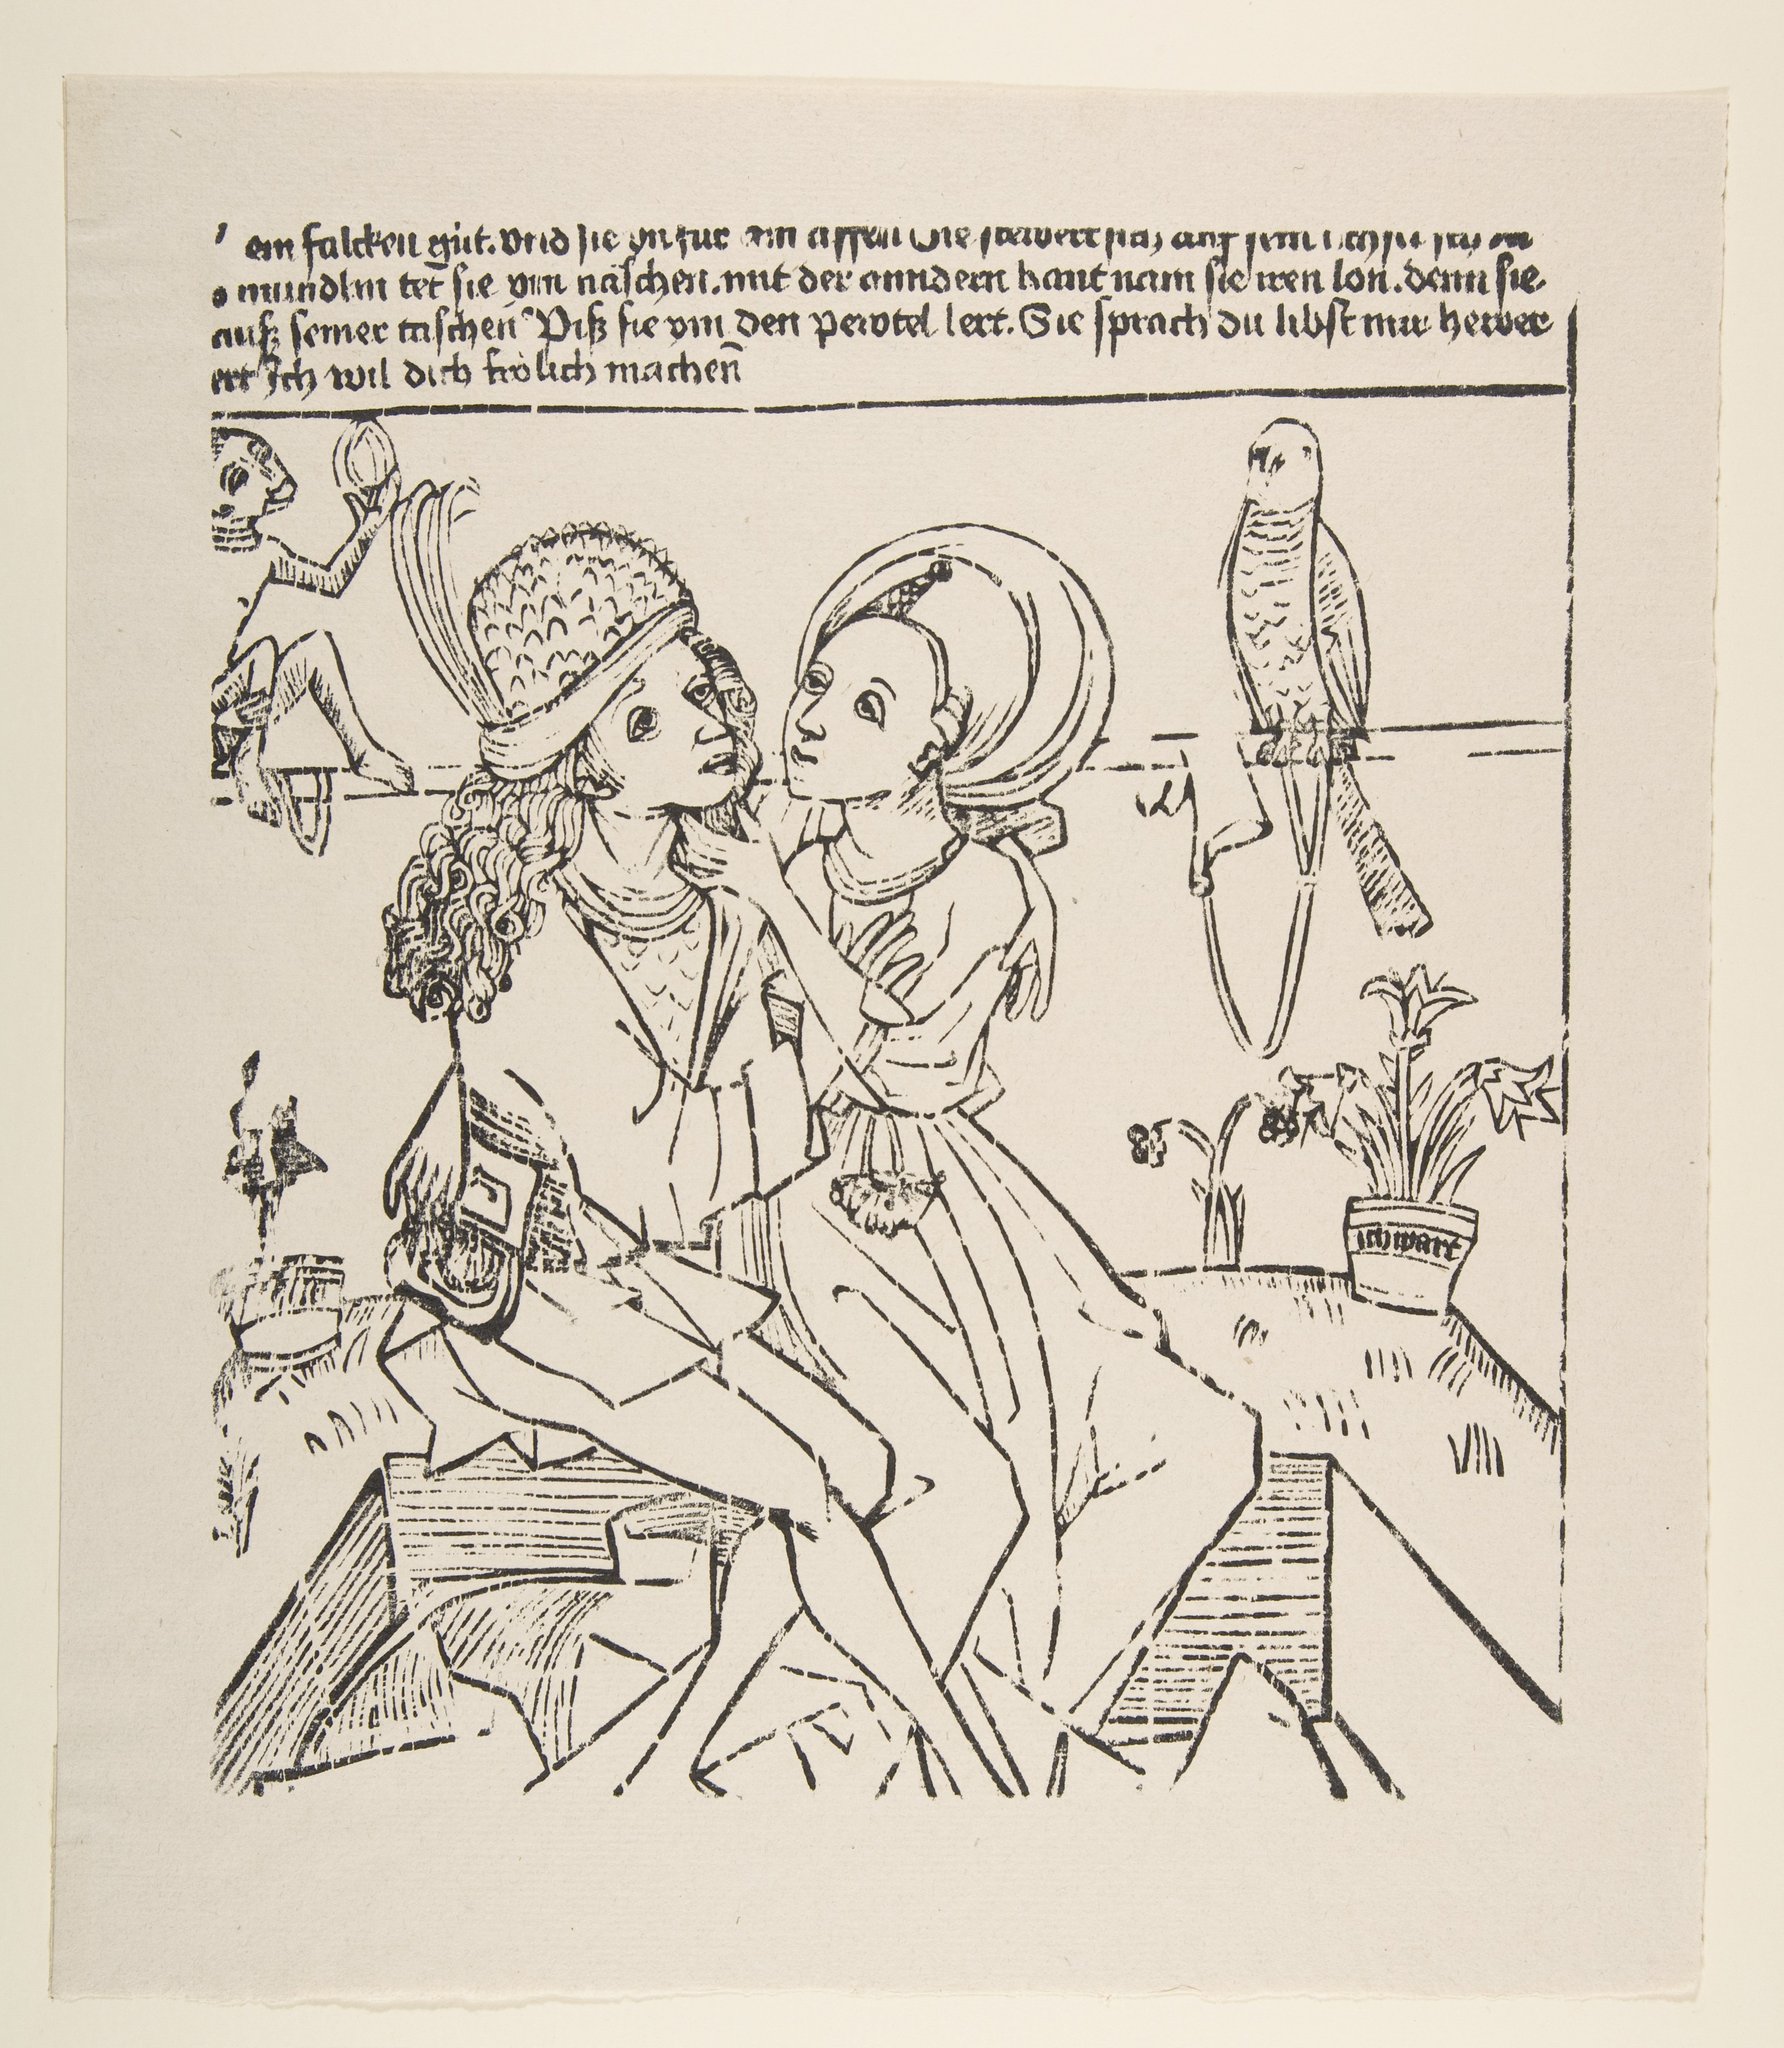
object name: print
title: Lovers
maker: anonymous, german, 15th century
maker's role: artist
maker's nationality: german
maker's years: 1400-1500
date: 1922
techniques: woodcut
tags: men,lovers,women,parrots